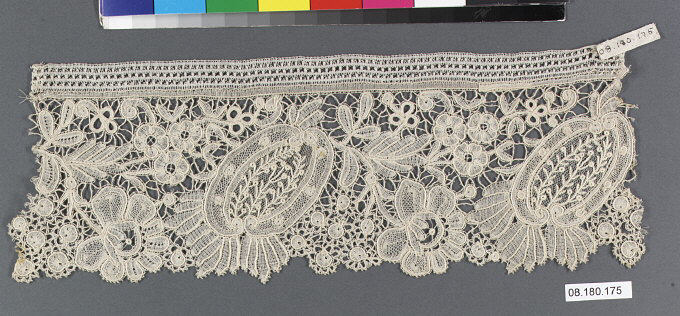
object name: piece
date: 1801-1900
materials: lace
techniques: lace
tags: flowers